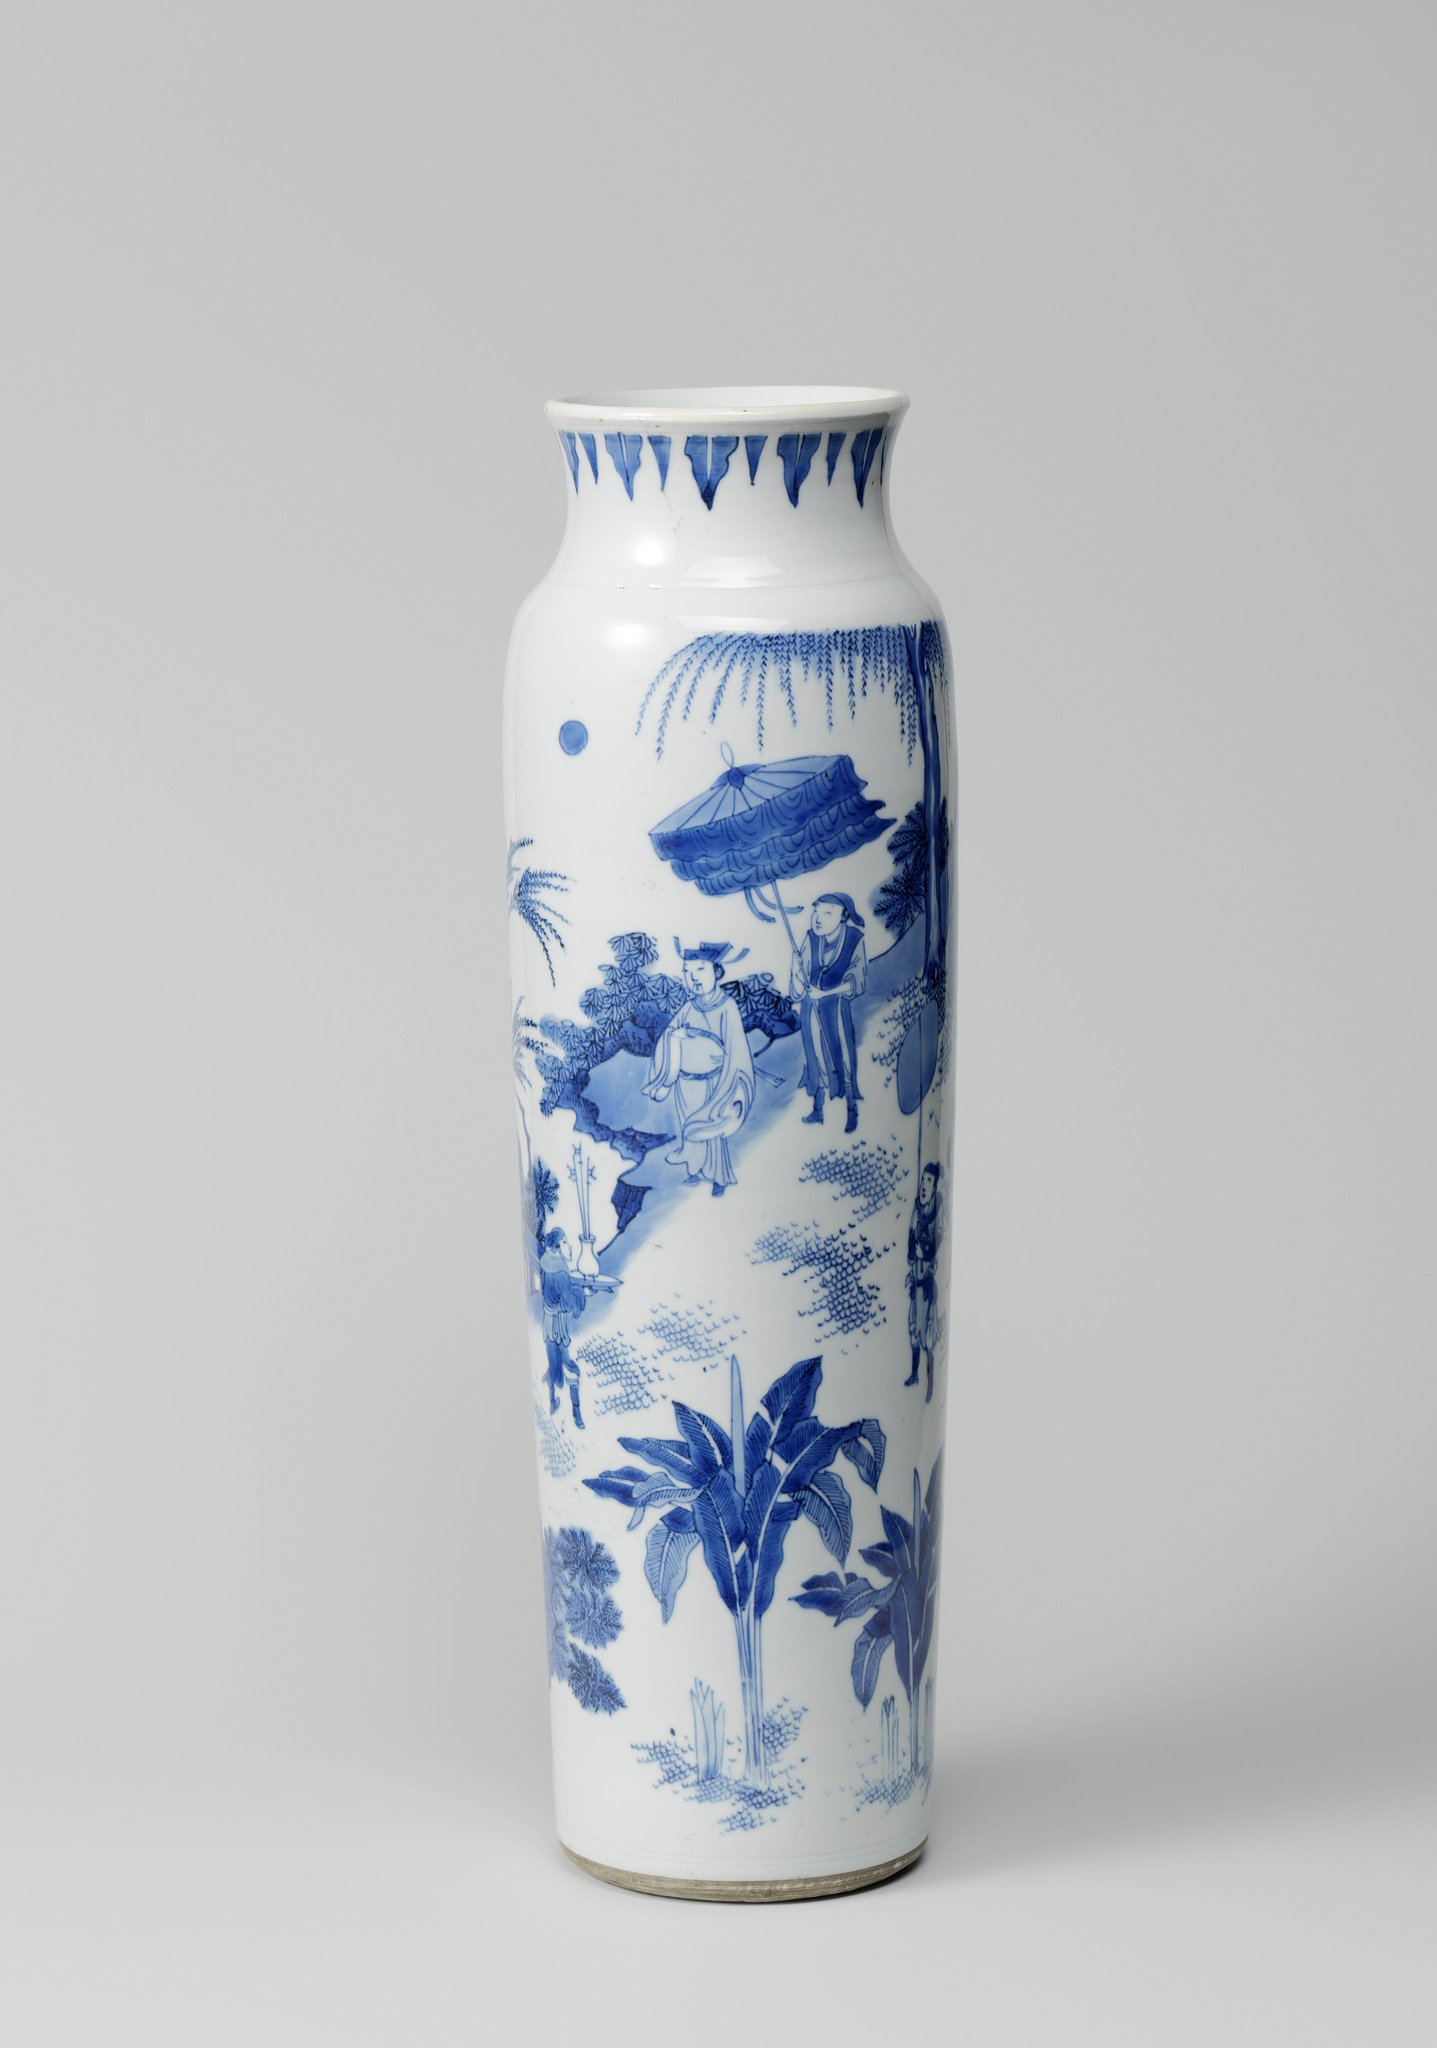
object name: rolwagen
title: Vase (rolwagen) with a company in a landscape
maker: Anonymous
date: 1635-1650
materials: cobalt, glaze, paint, porcelain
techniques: firing, turning, vitrification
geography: china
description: AK-NM-6671 Rolwagen • Overgangsporselein • Onderdeel van Royers porseleincollectie • Rolwagen • Op de bodem in pen: ‘T22’ (slecht leesbaar) en in potlood: ‘No28’. Betekenis onbekend • Met dank aan Fan Lin, Qinxin He and Erika Riccobon, Universiteit Leiden, voor informatie over de voorstelling Een hoogwaardigheidsbekleder krijgt een vaas aangeboden met drie kleine hellebaarden. Dit motief drukt de wens uit op een snelle promotie van drie rangen. Het karakter voor hellebaard (ji) is homofoon met het karakter voor officiële rang, vaas (ping) klink als probleemloos. Zo kan het aanbieden van een vaas met drie hellebaarden direct herkend worden als het uitspreken van de wens dat de ontvanger zonder moeite drie rangen stijgt in de Chinese ambtenaren-hiërarchie. De voorstelling is vrijwel gelijk aan die op AK-NM-6680, maar het schilderwerk (weergave van de figuren, de details) is eenvoudiger.